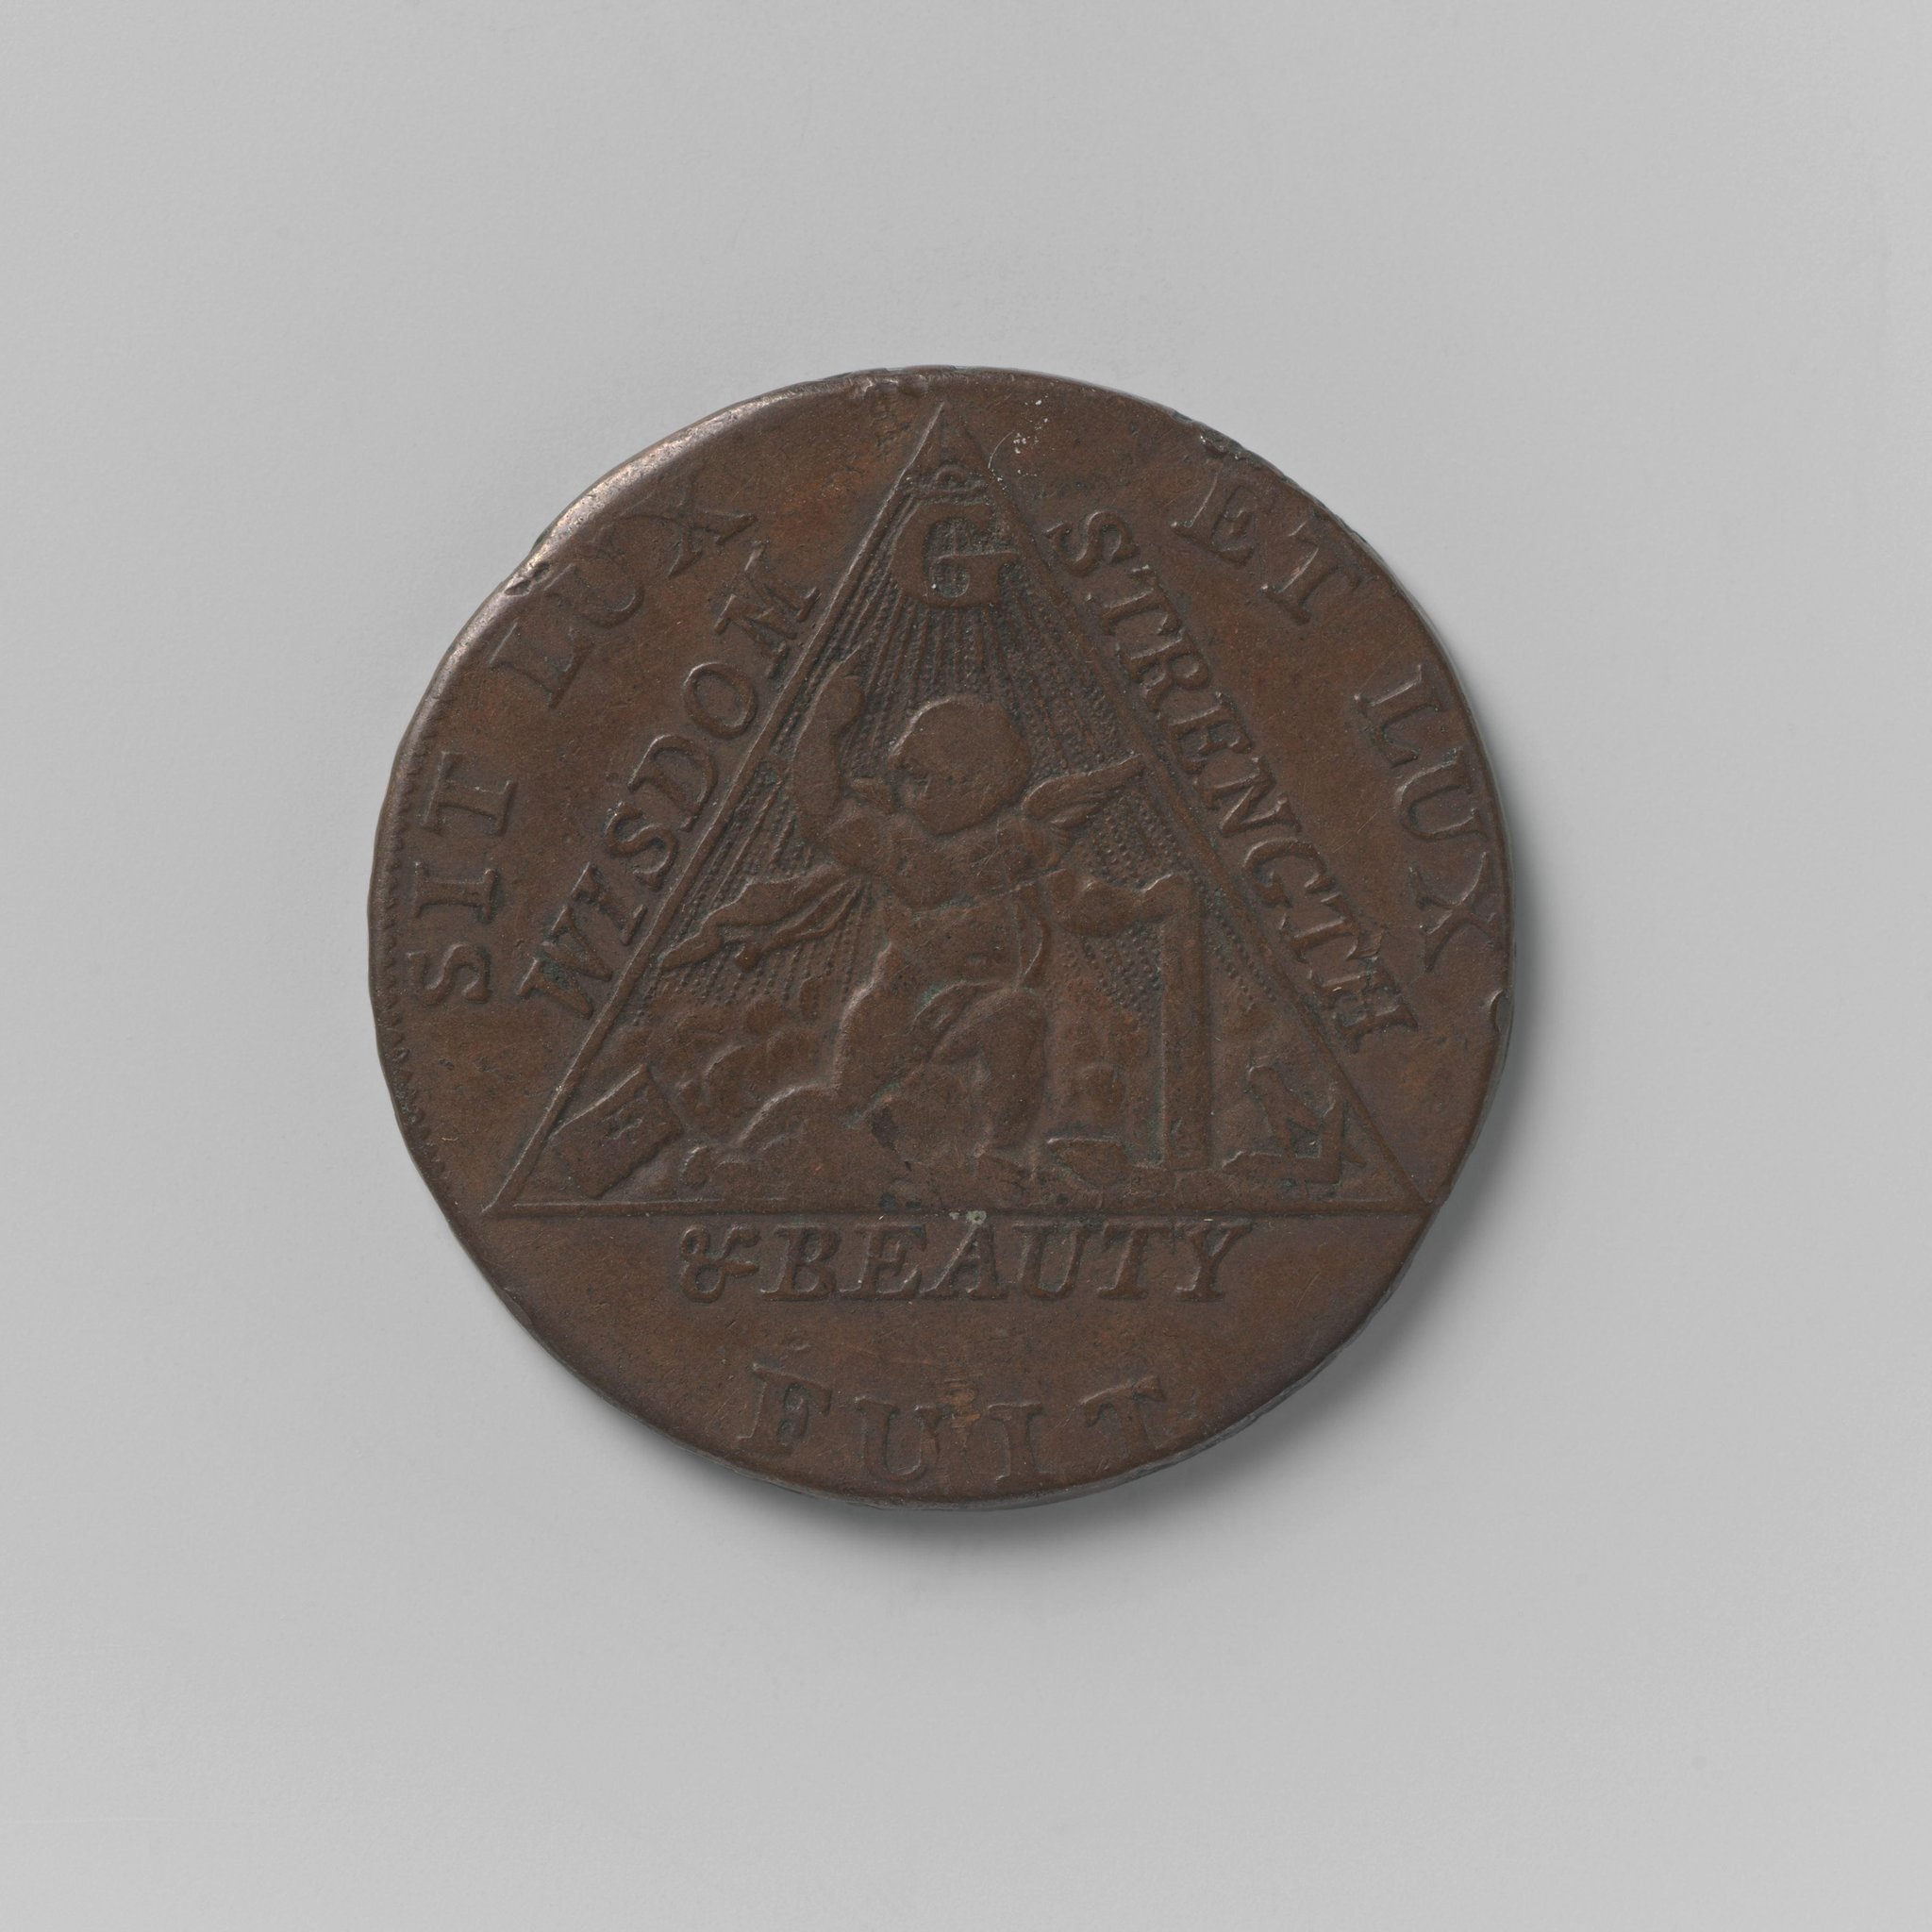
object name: penny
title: Maconnieke token voor een penny uit Birmingham, Engeland, 1794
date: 1794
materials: copper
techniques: striking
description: Koperen particuliere munt. Voorzijde: door twee vossen gehouden wapenschild, waaronder wapenspreuk. Keerzijde: driehoek, waarin maconnieke tekens. Randschrift.